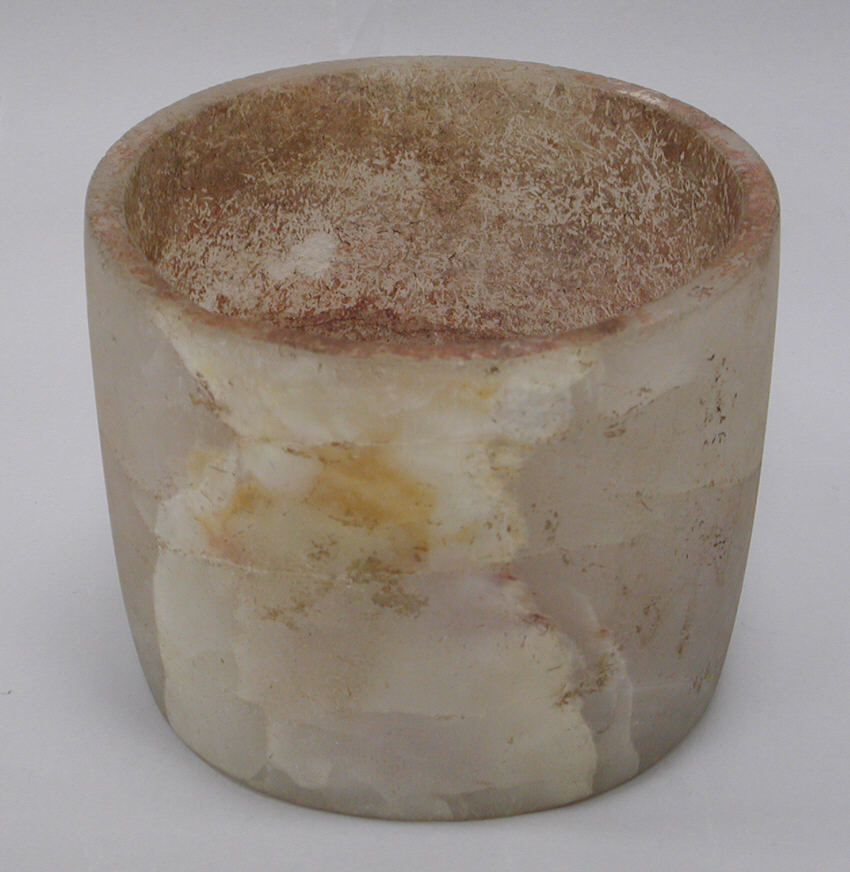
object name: bowl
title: Onyx Bowl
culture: mexican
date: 1501-1600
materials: marble, onyx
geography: mexico